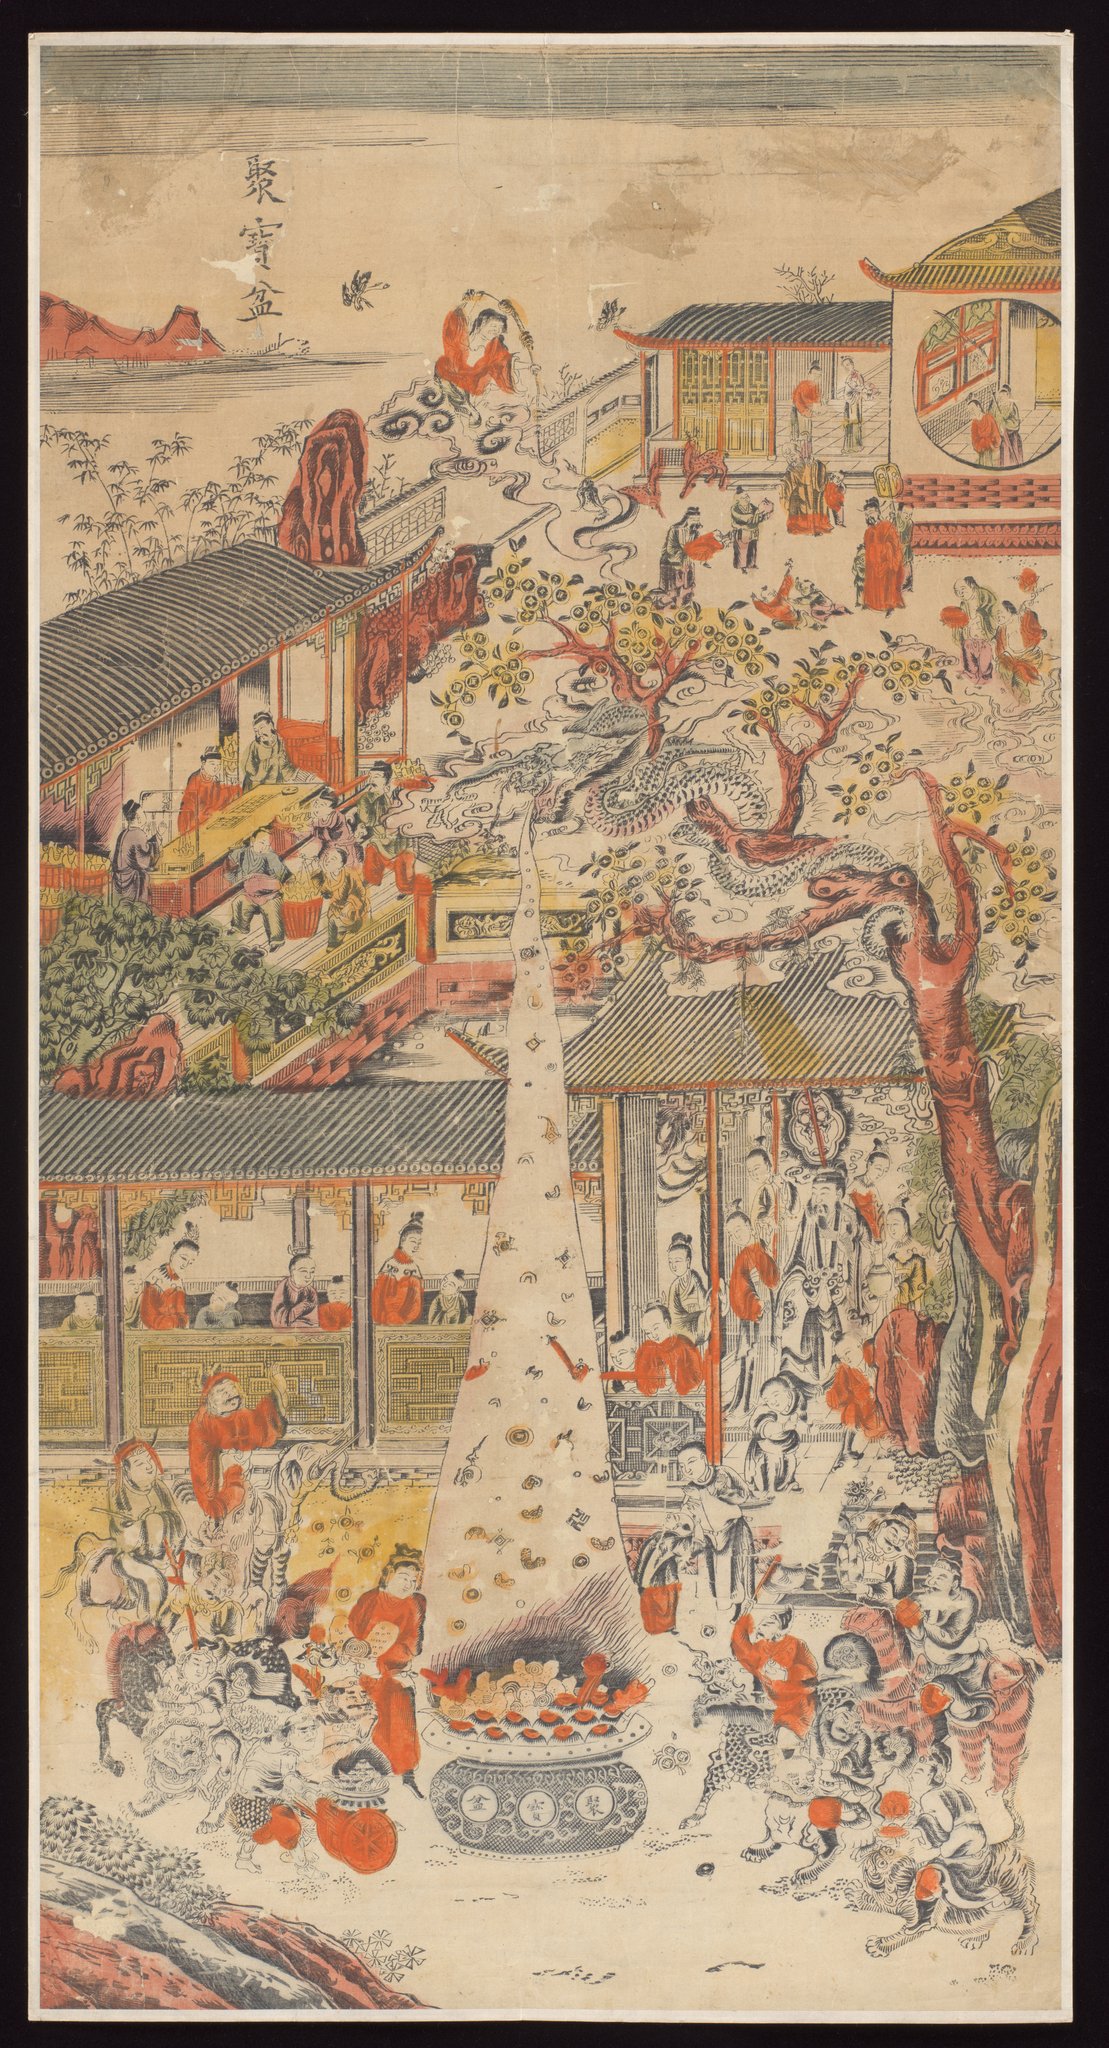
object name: print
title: Basin of Accumulated Treasures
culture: chinese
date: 1701-1800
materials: ink, paper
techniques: hand coloring, woodblock print